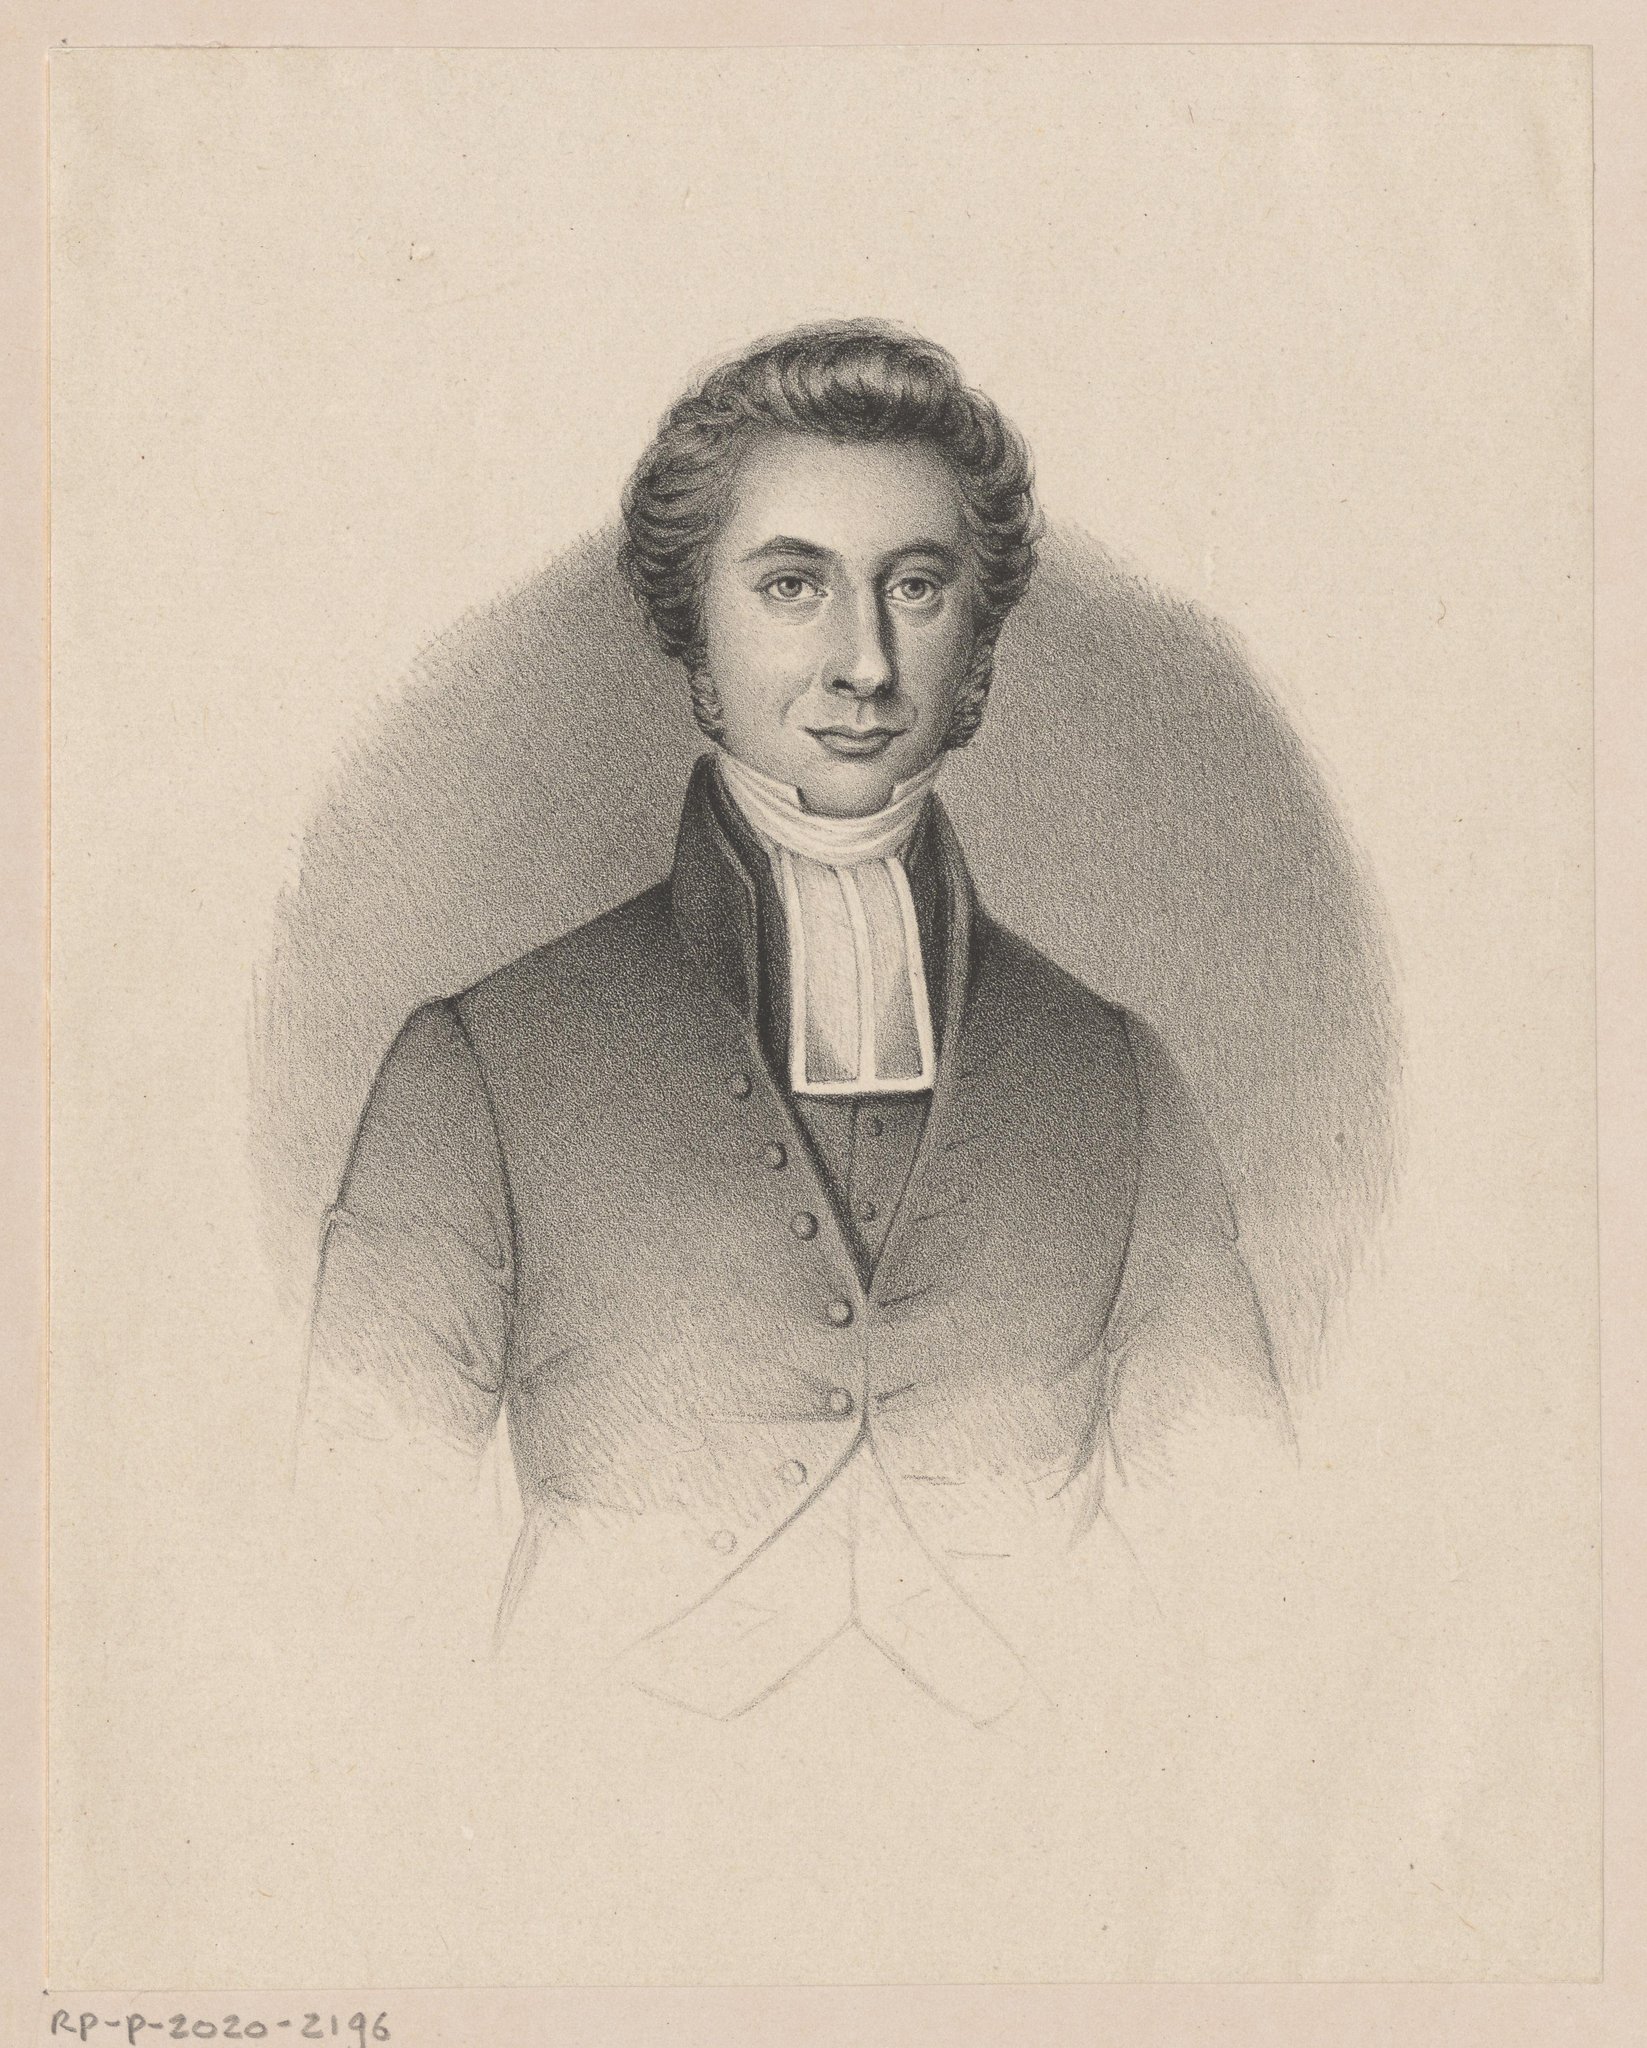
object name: print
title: Portret van Ferdinand Jacob Domela Nieuwenhuis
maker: Anonymous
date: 1810-1899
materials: paper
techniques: lithograph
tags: utrecht, historical persons, functionaries and dignitaries ~ protestant churches